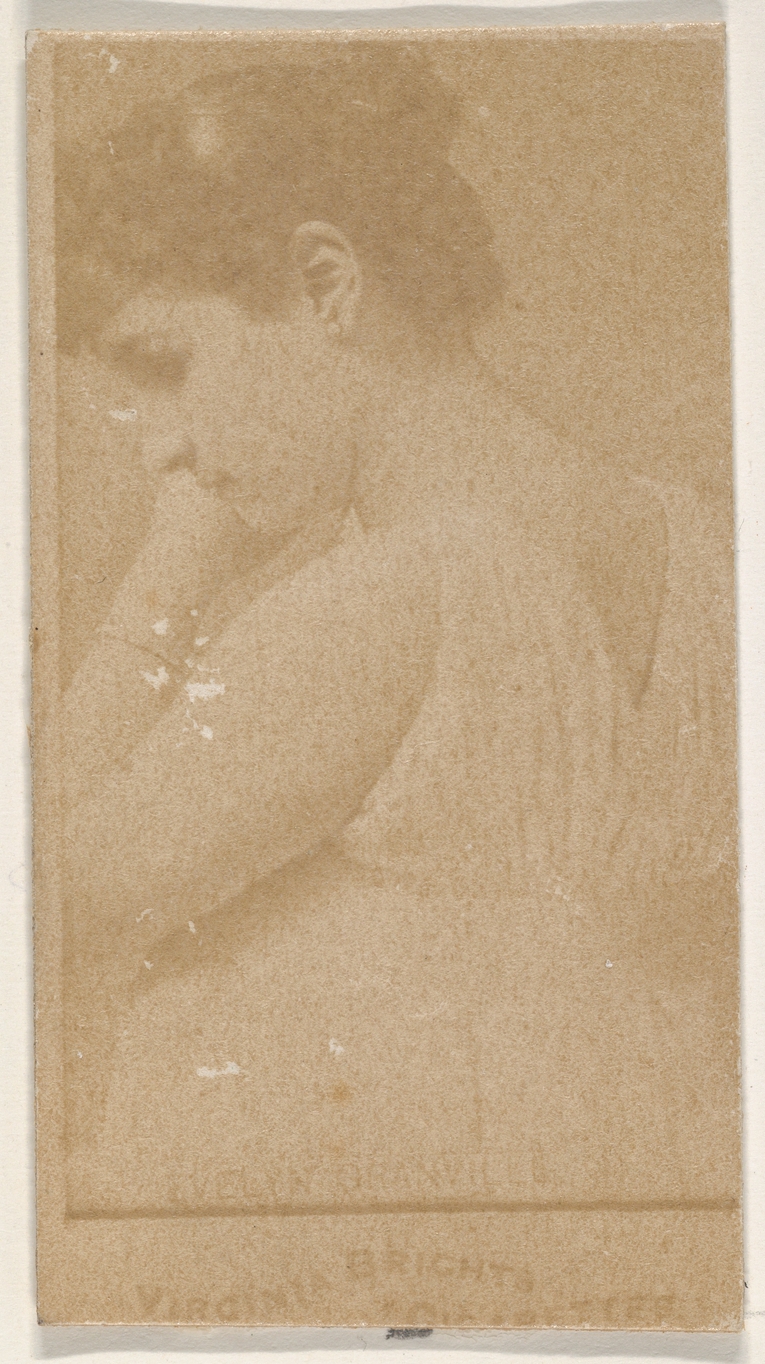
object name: photograph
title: Evelyn Osanville, From the Actors and Actresses series (N45, Type 1) for Virginia Brights Cigarettes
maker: allen & ginter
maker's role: publisher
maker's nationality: american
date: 1888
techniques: albumen silver print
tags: portraits,women,actresses